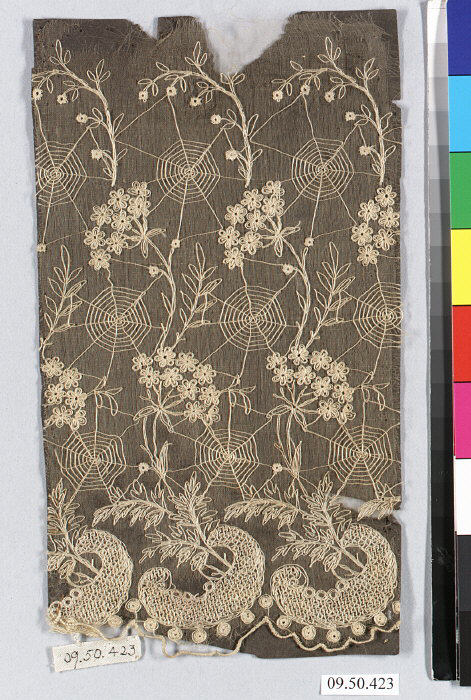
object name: piece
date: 1801-1900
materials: cotton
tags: leaves